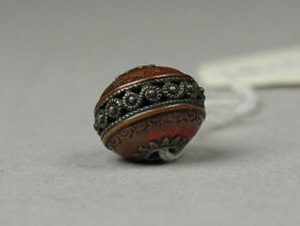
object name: ojime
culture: japanese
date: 1801-1900